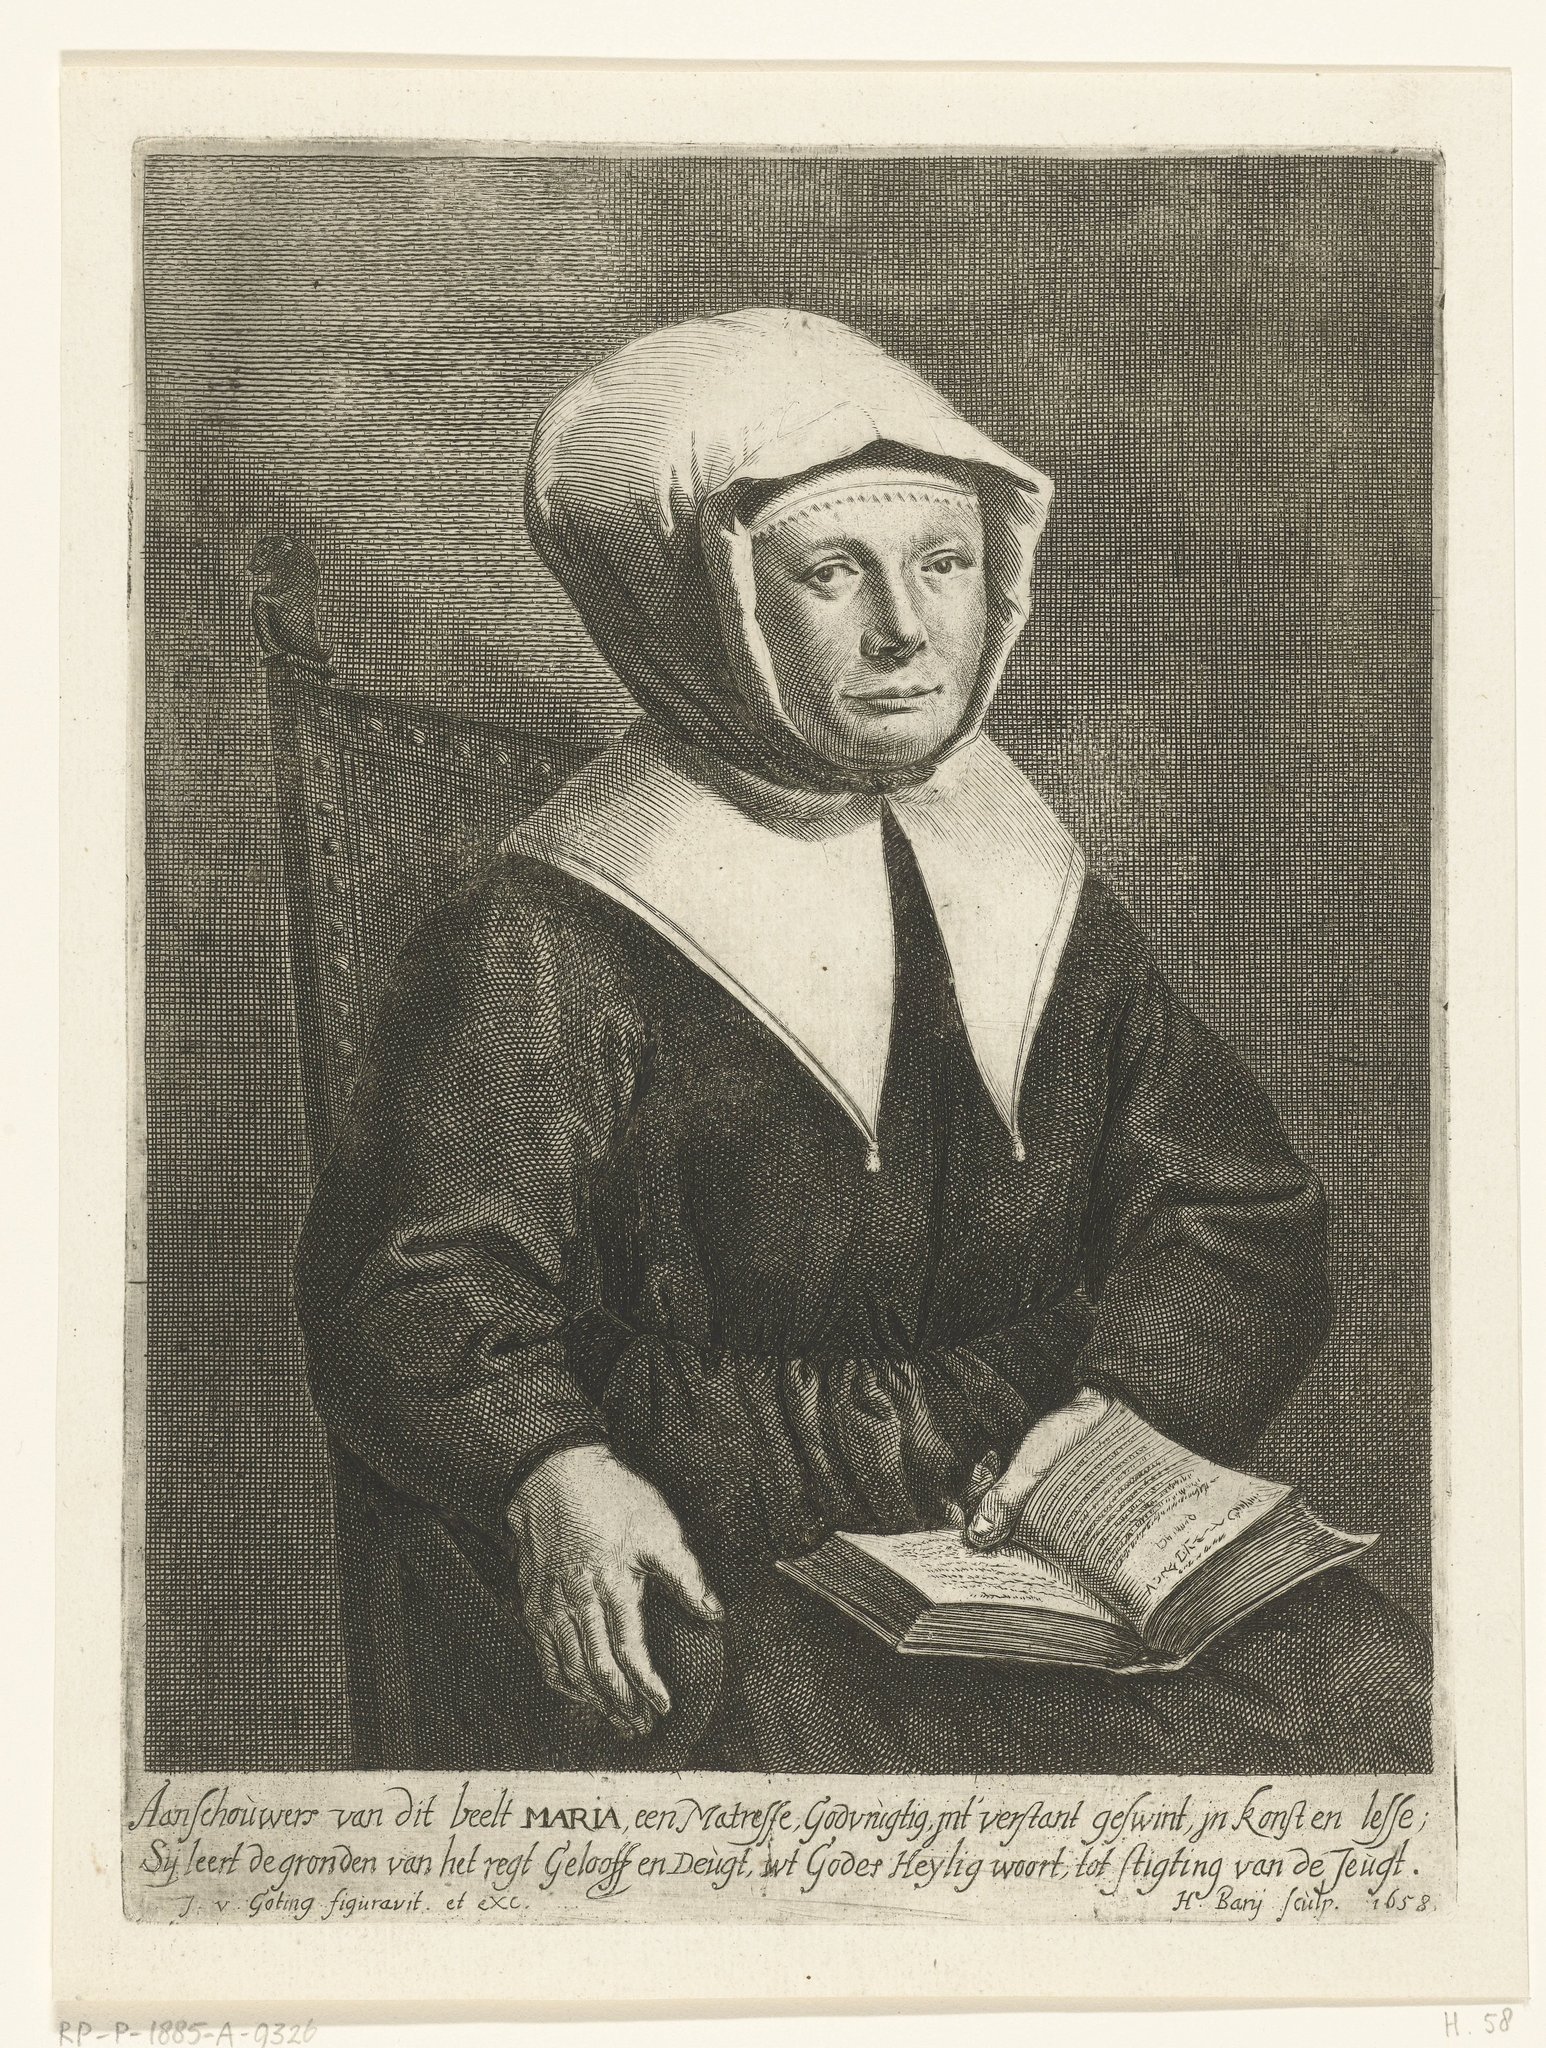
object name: print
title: Portret van Maria de godsdienstonderwijzeres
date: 1658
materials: paper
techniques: engraving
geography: haarlem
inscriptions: collector's mark: Lugt 2228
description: Portret van een vrouw met een wit kapje op haar hoofd en een boek in haar schoot. Met een onderschrift van twee regels in het Nederlands.